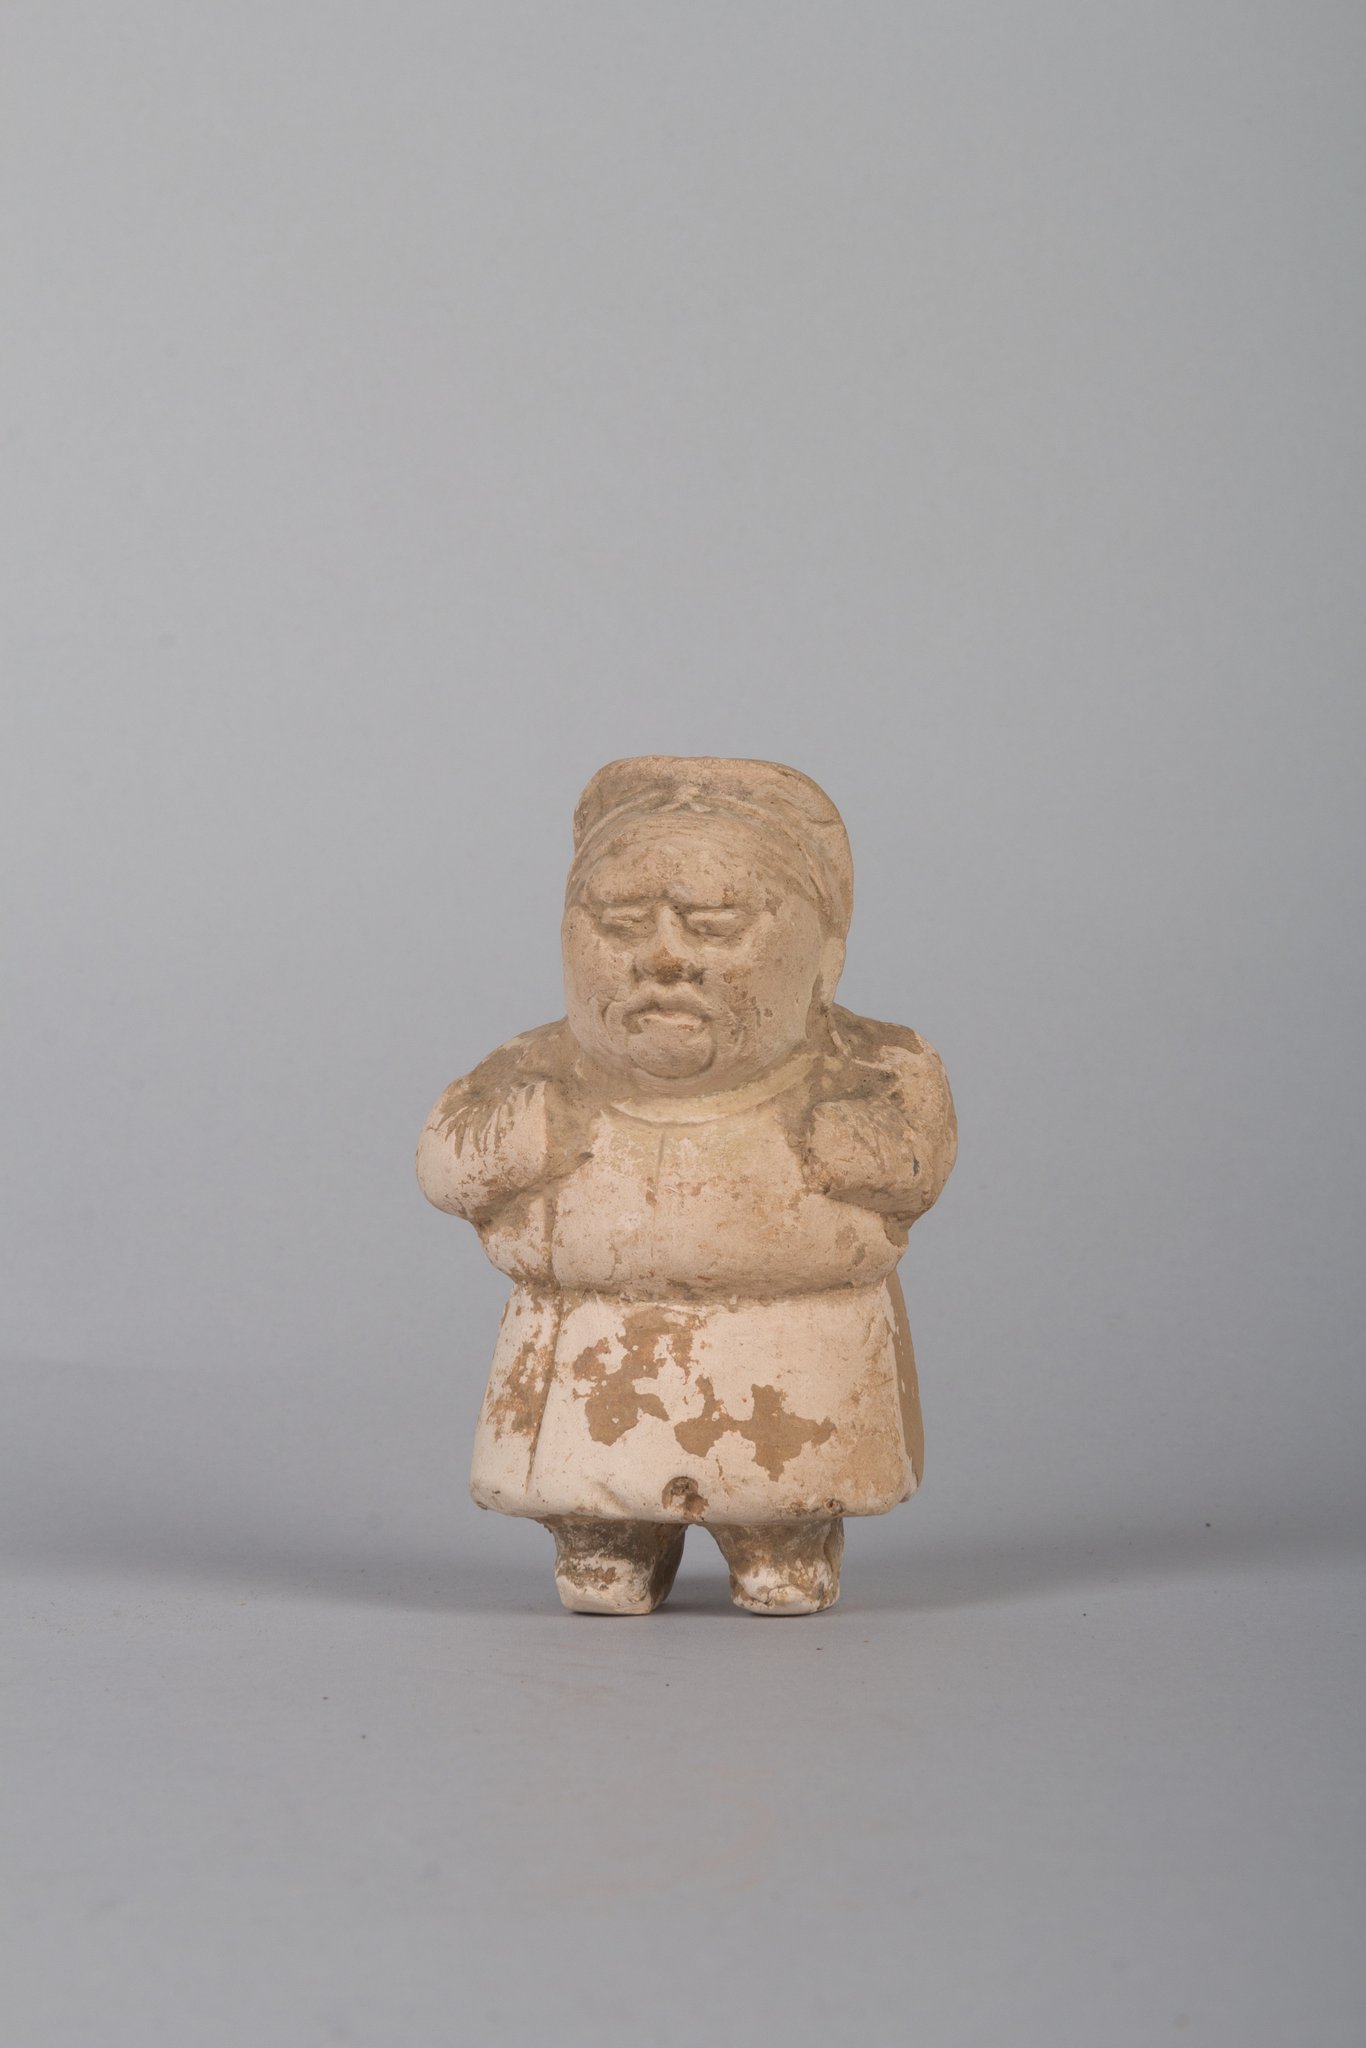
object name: figure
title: Dwarf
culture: chinese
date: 601-800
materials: earthenware